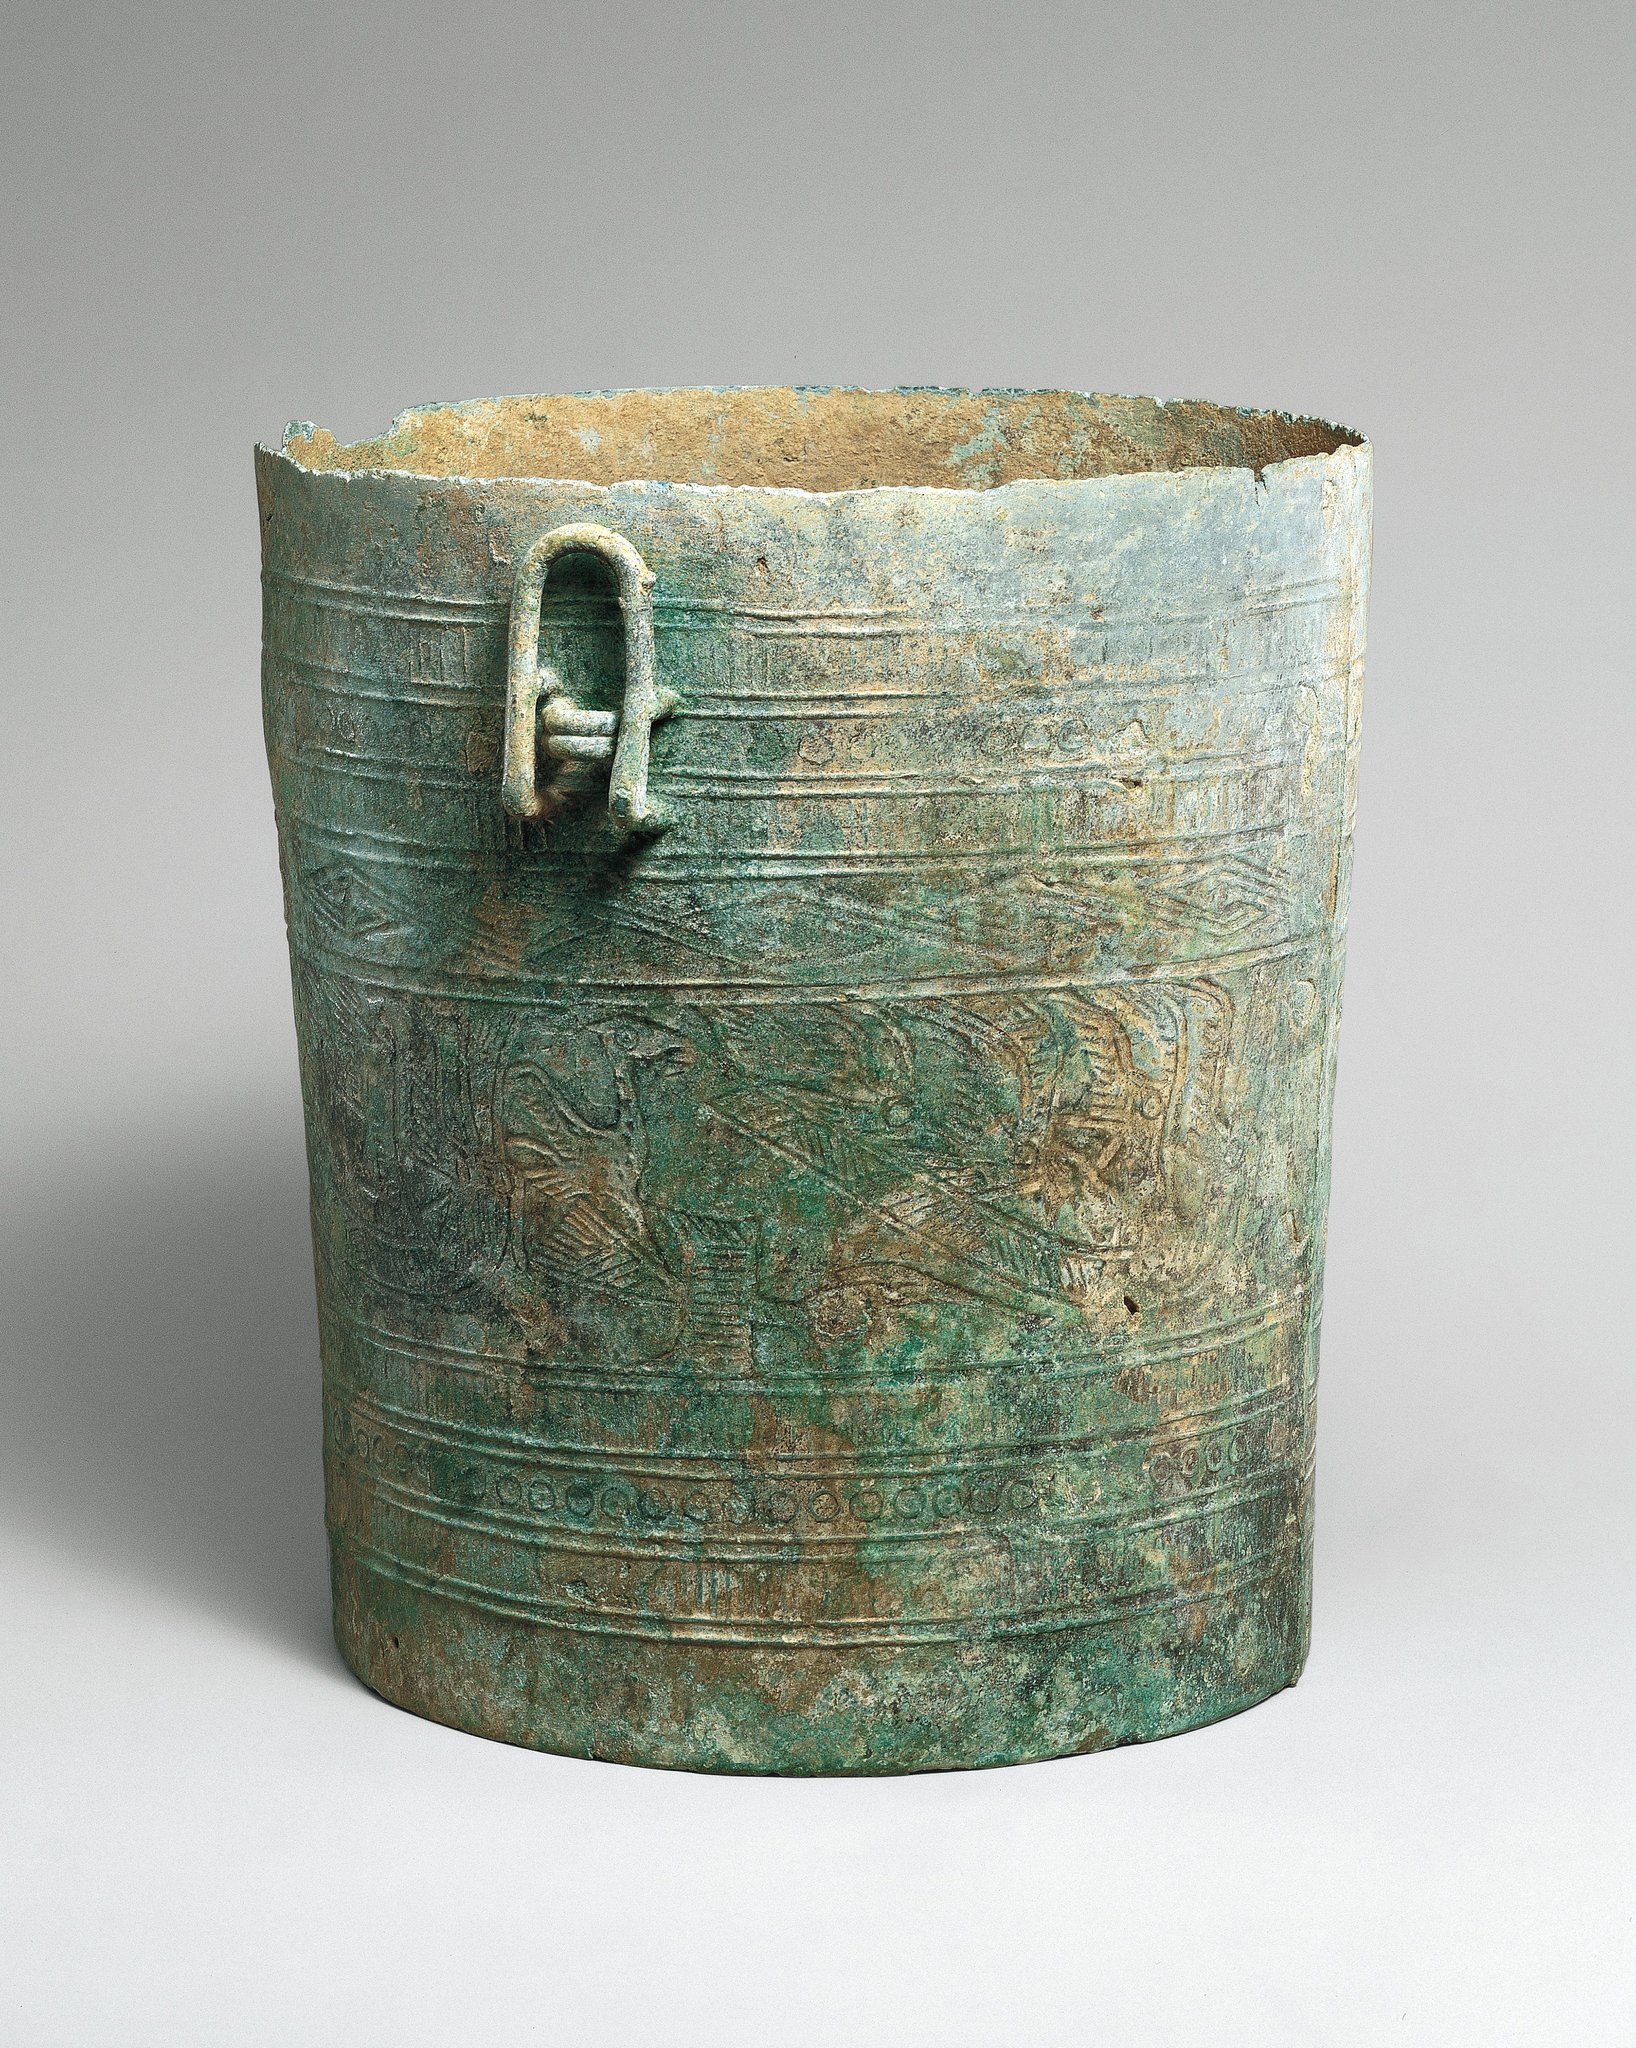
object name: situla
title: Situla with Design of Boats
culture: vietnamese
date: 500 BCE-300 CE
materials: bronze